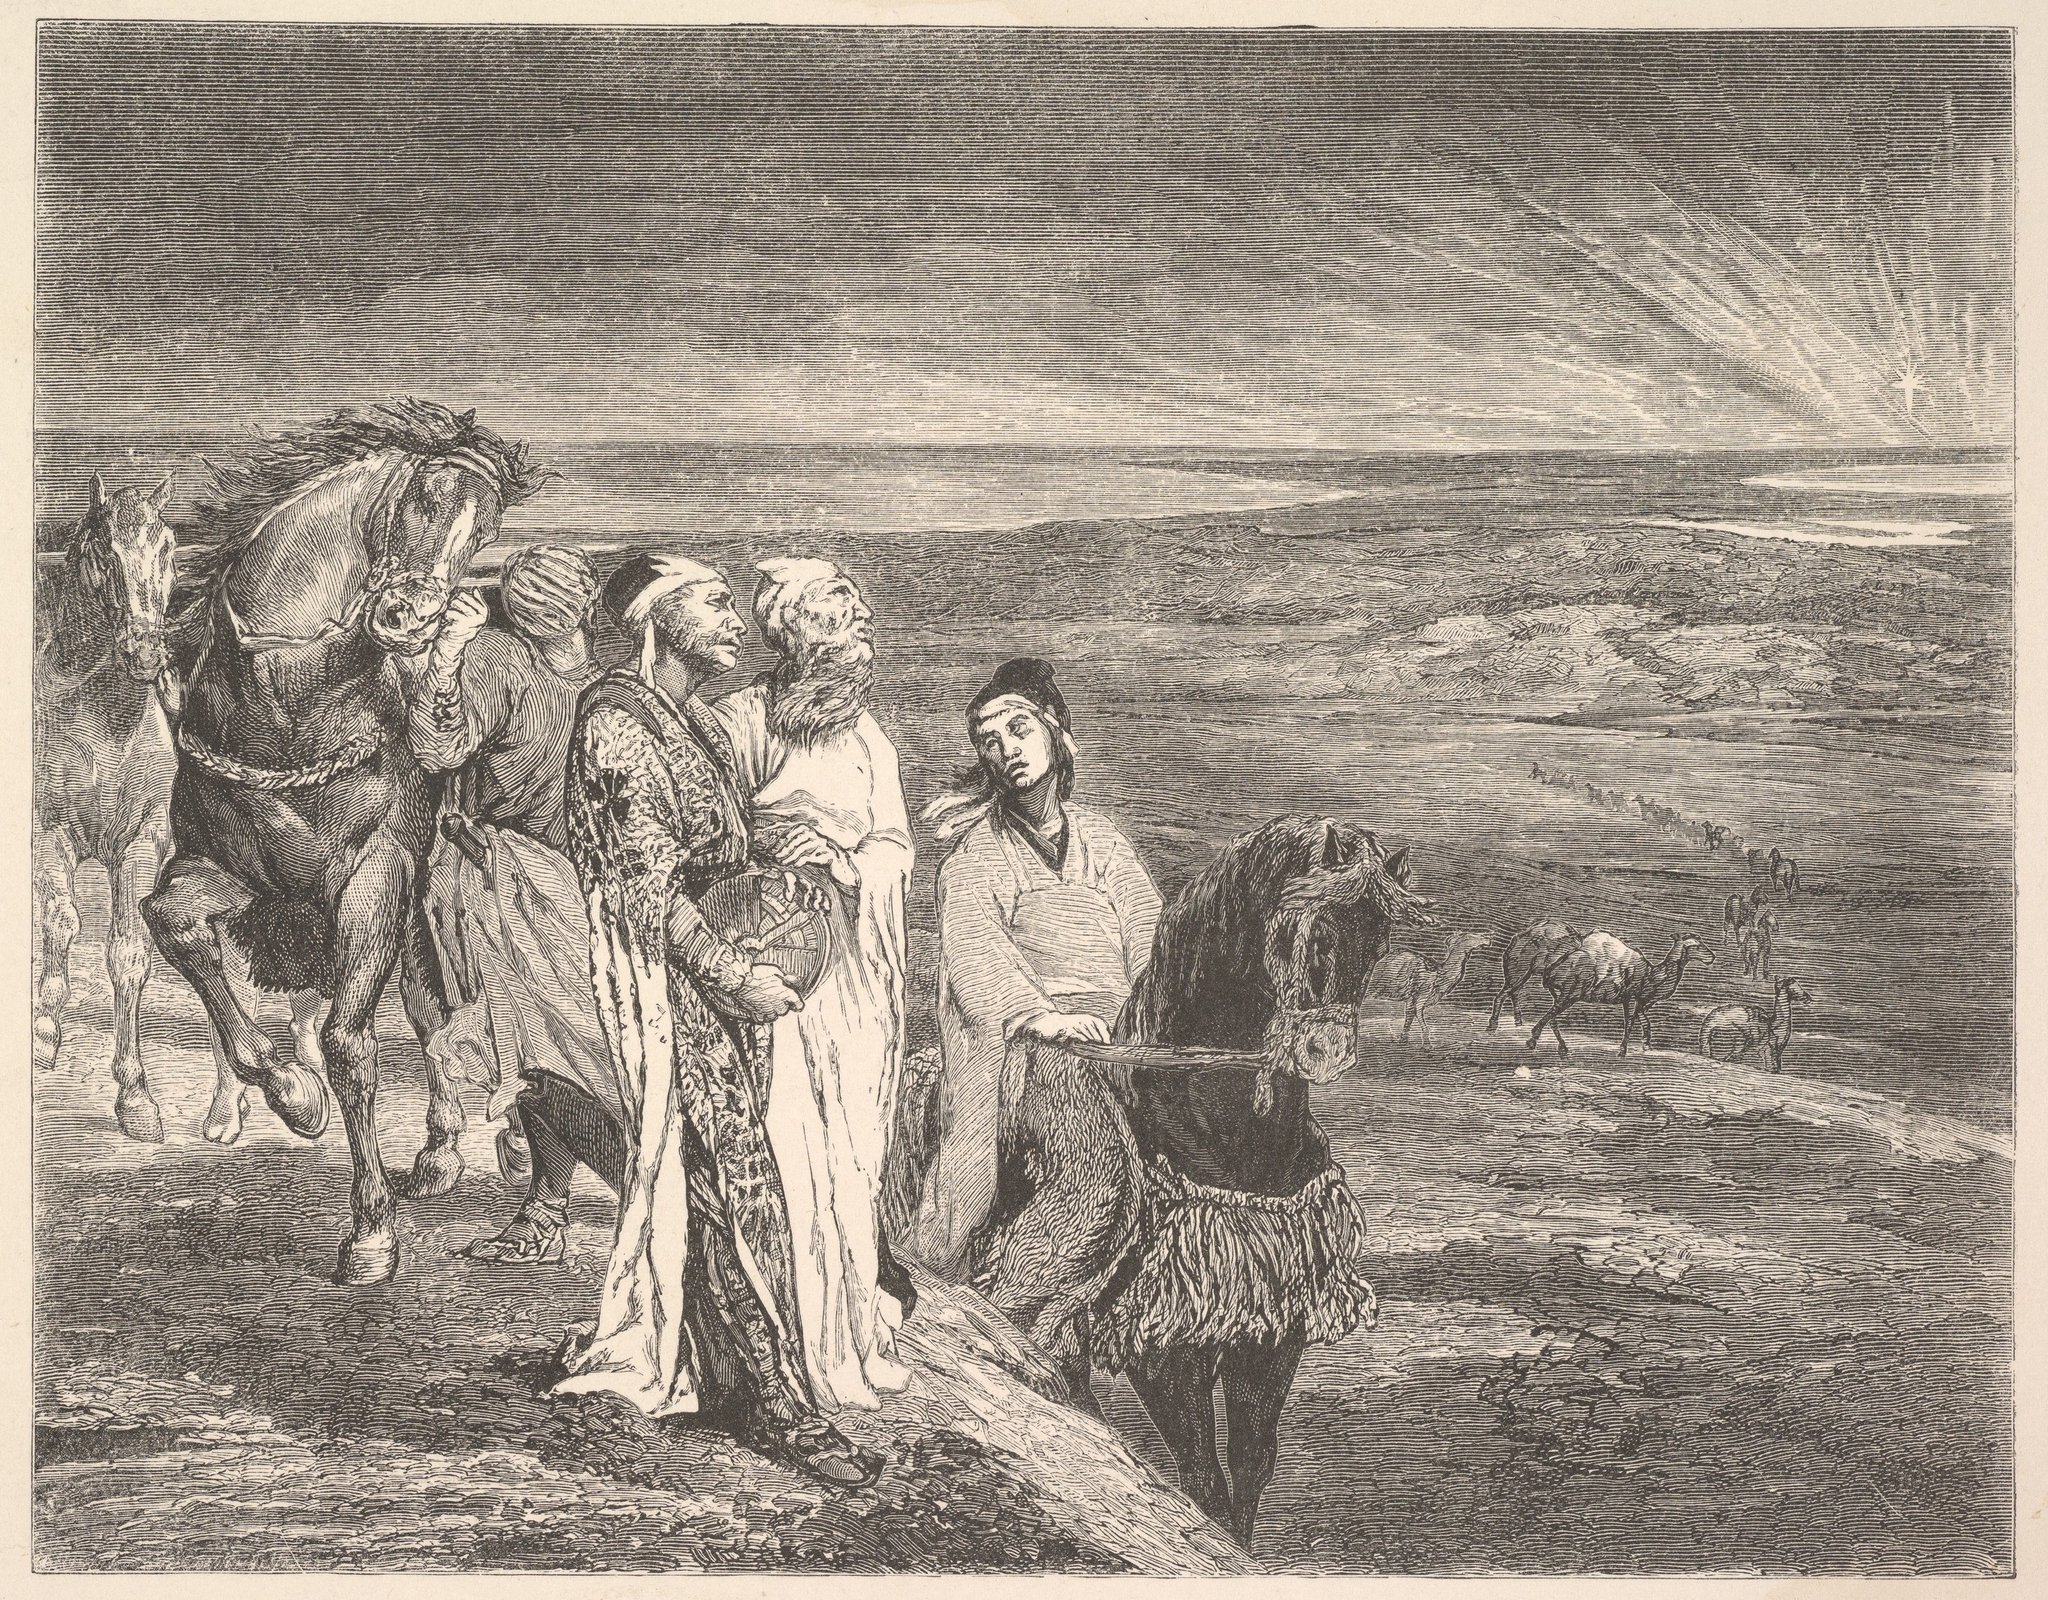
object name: print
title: The Wise Men out of the East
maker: john la farge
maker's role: artist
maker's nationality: american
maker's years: 1835-1910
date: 1868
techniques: engraving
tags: animals,men,horses